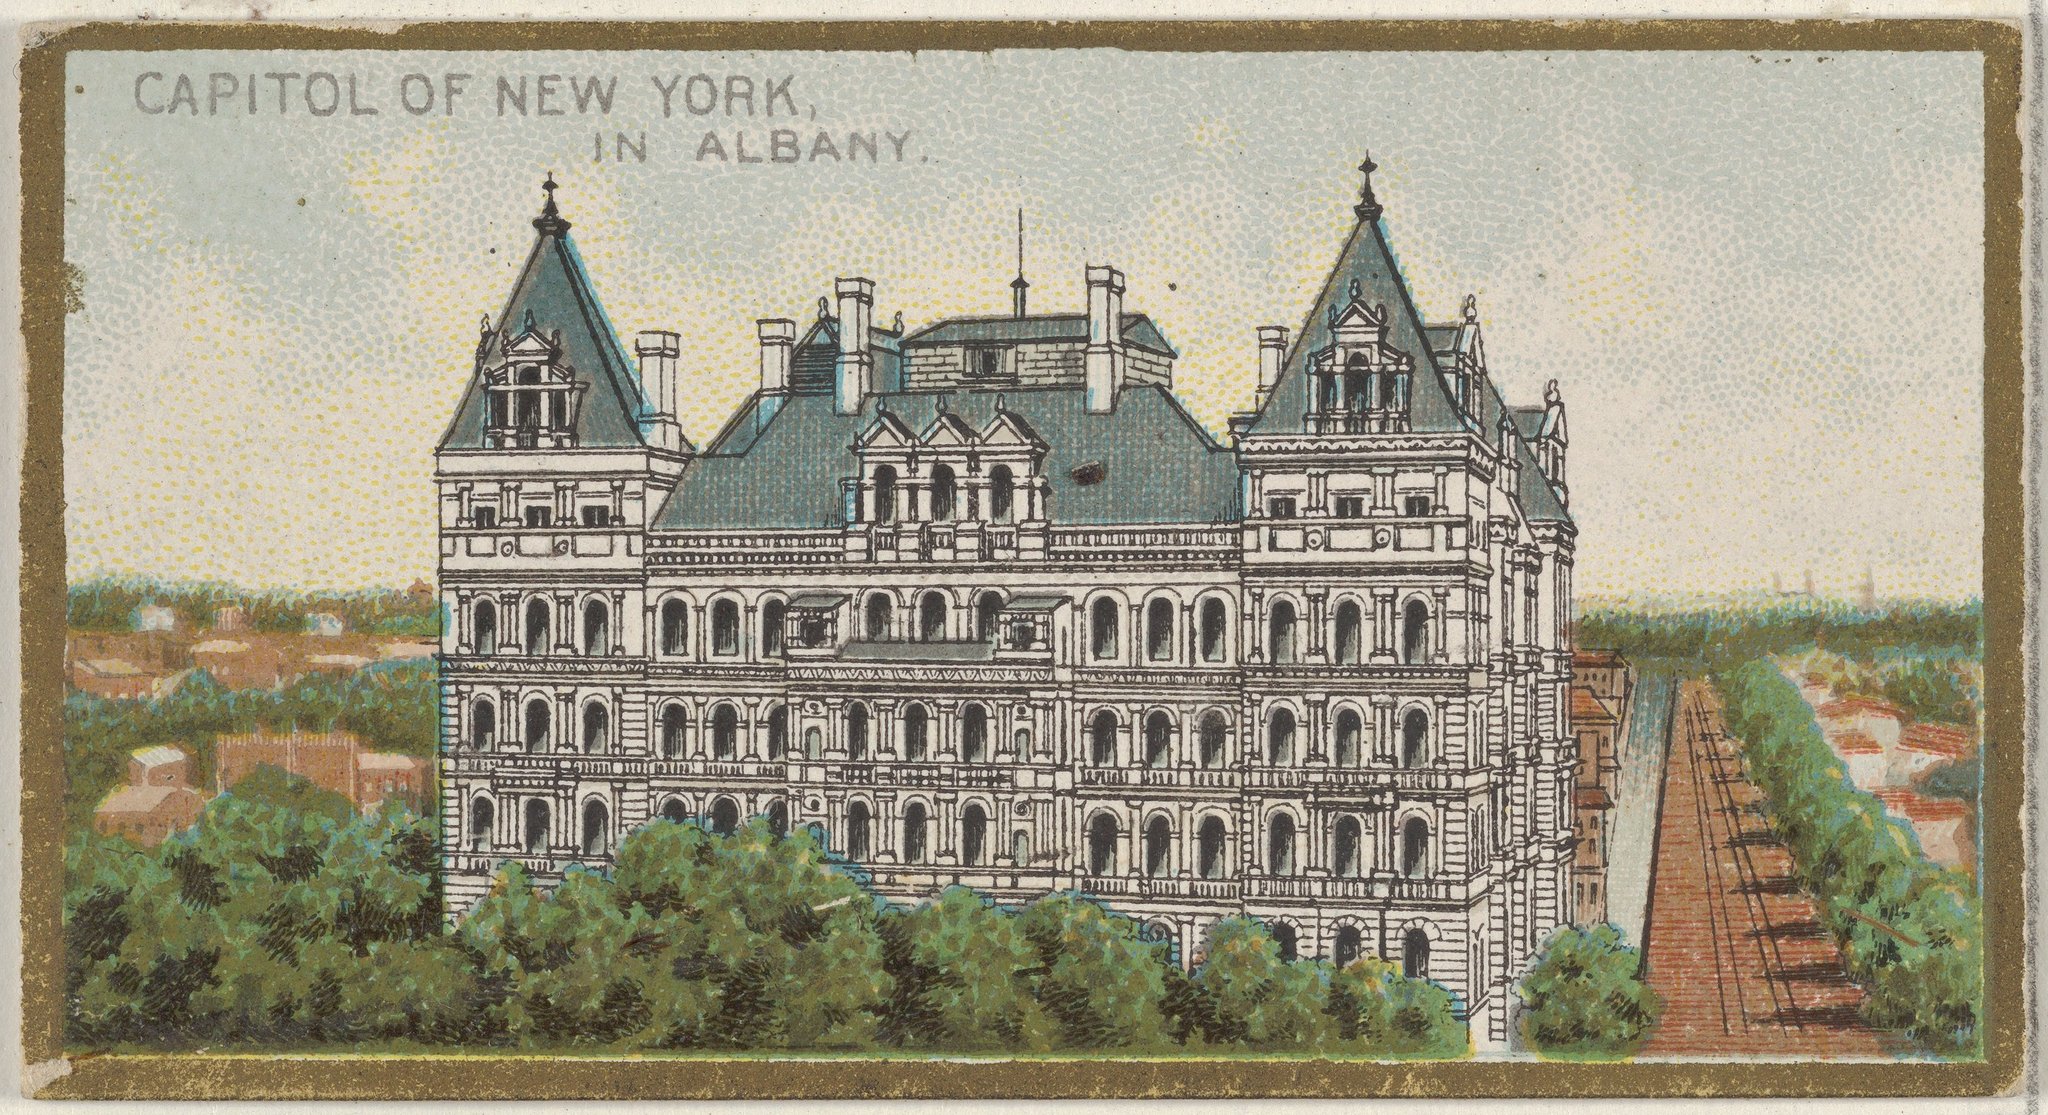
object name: print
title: Capitol of New York in Albany, from the General Government and State Capitol Buildings series (N14) for Allen & Ginter Cigarettes Brands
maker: allen & ginter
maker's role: publisher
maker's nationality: american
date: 1889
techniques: color lithograph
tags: buildings